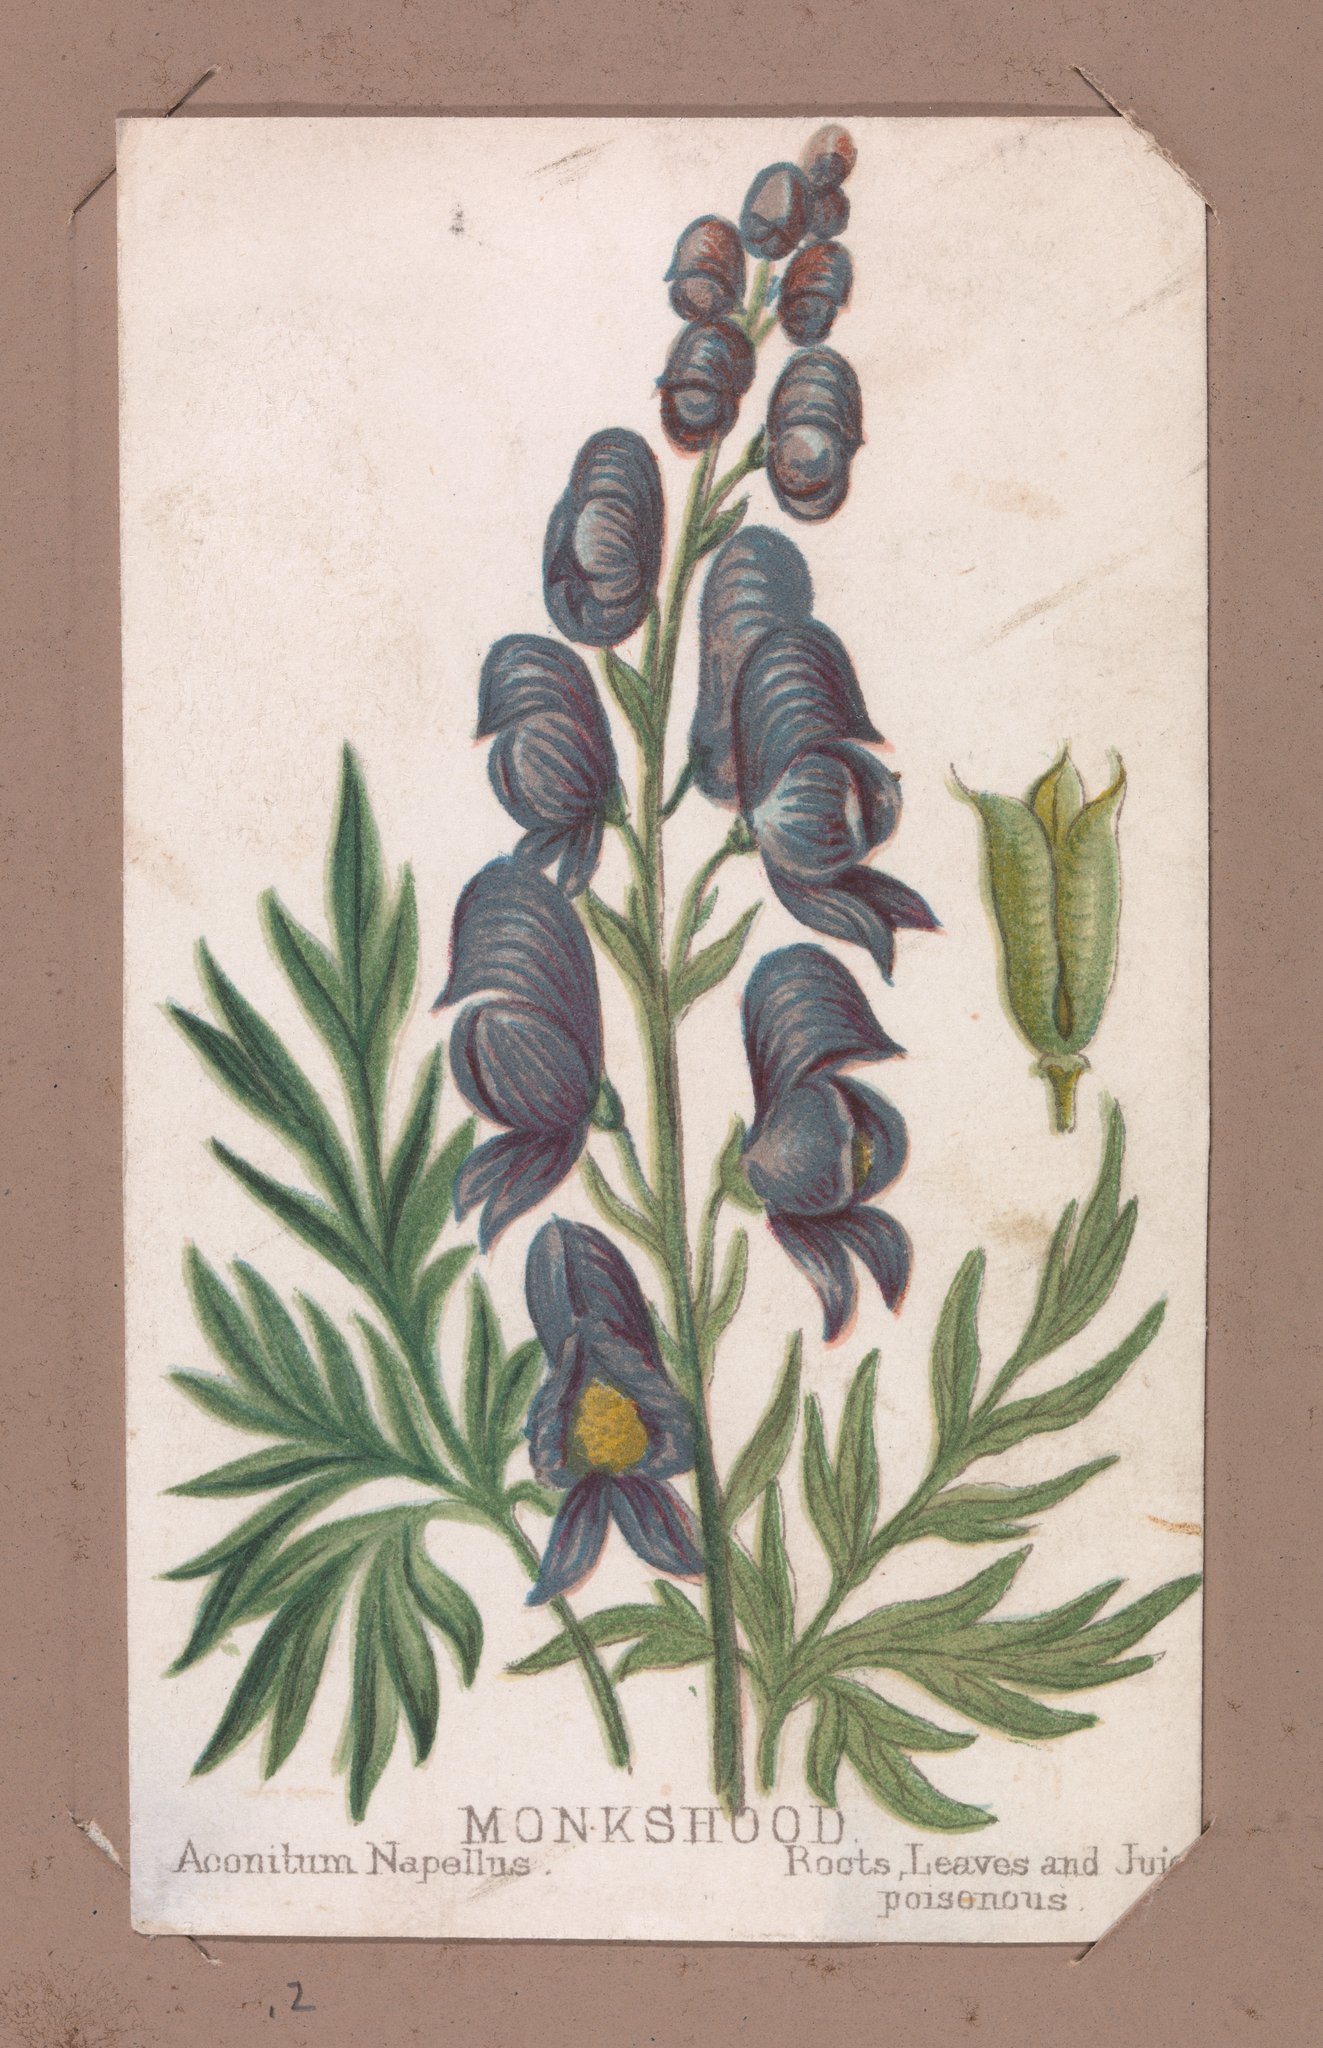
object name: album card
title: Monkshood from the Plants series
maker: louis prang & co.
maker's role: publisher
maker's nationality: american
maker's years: 1800-1950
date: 1862-1869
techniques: lithograph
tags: plants